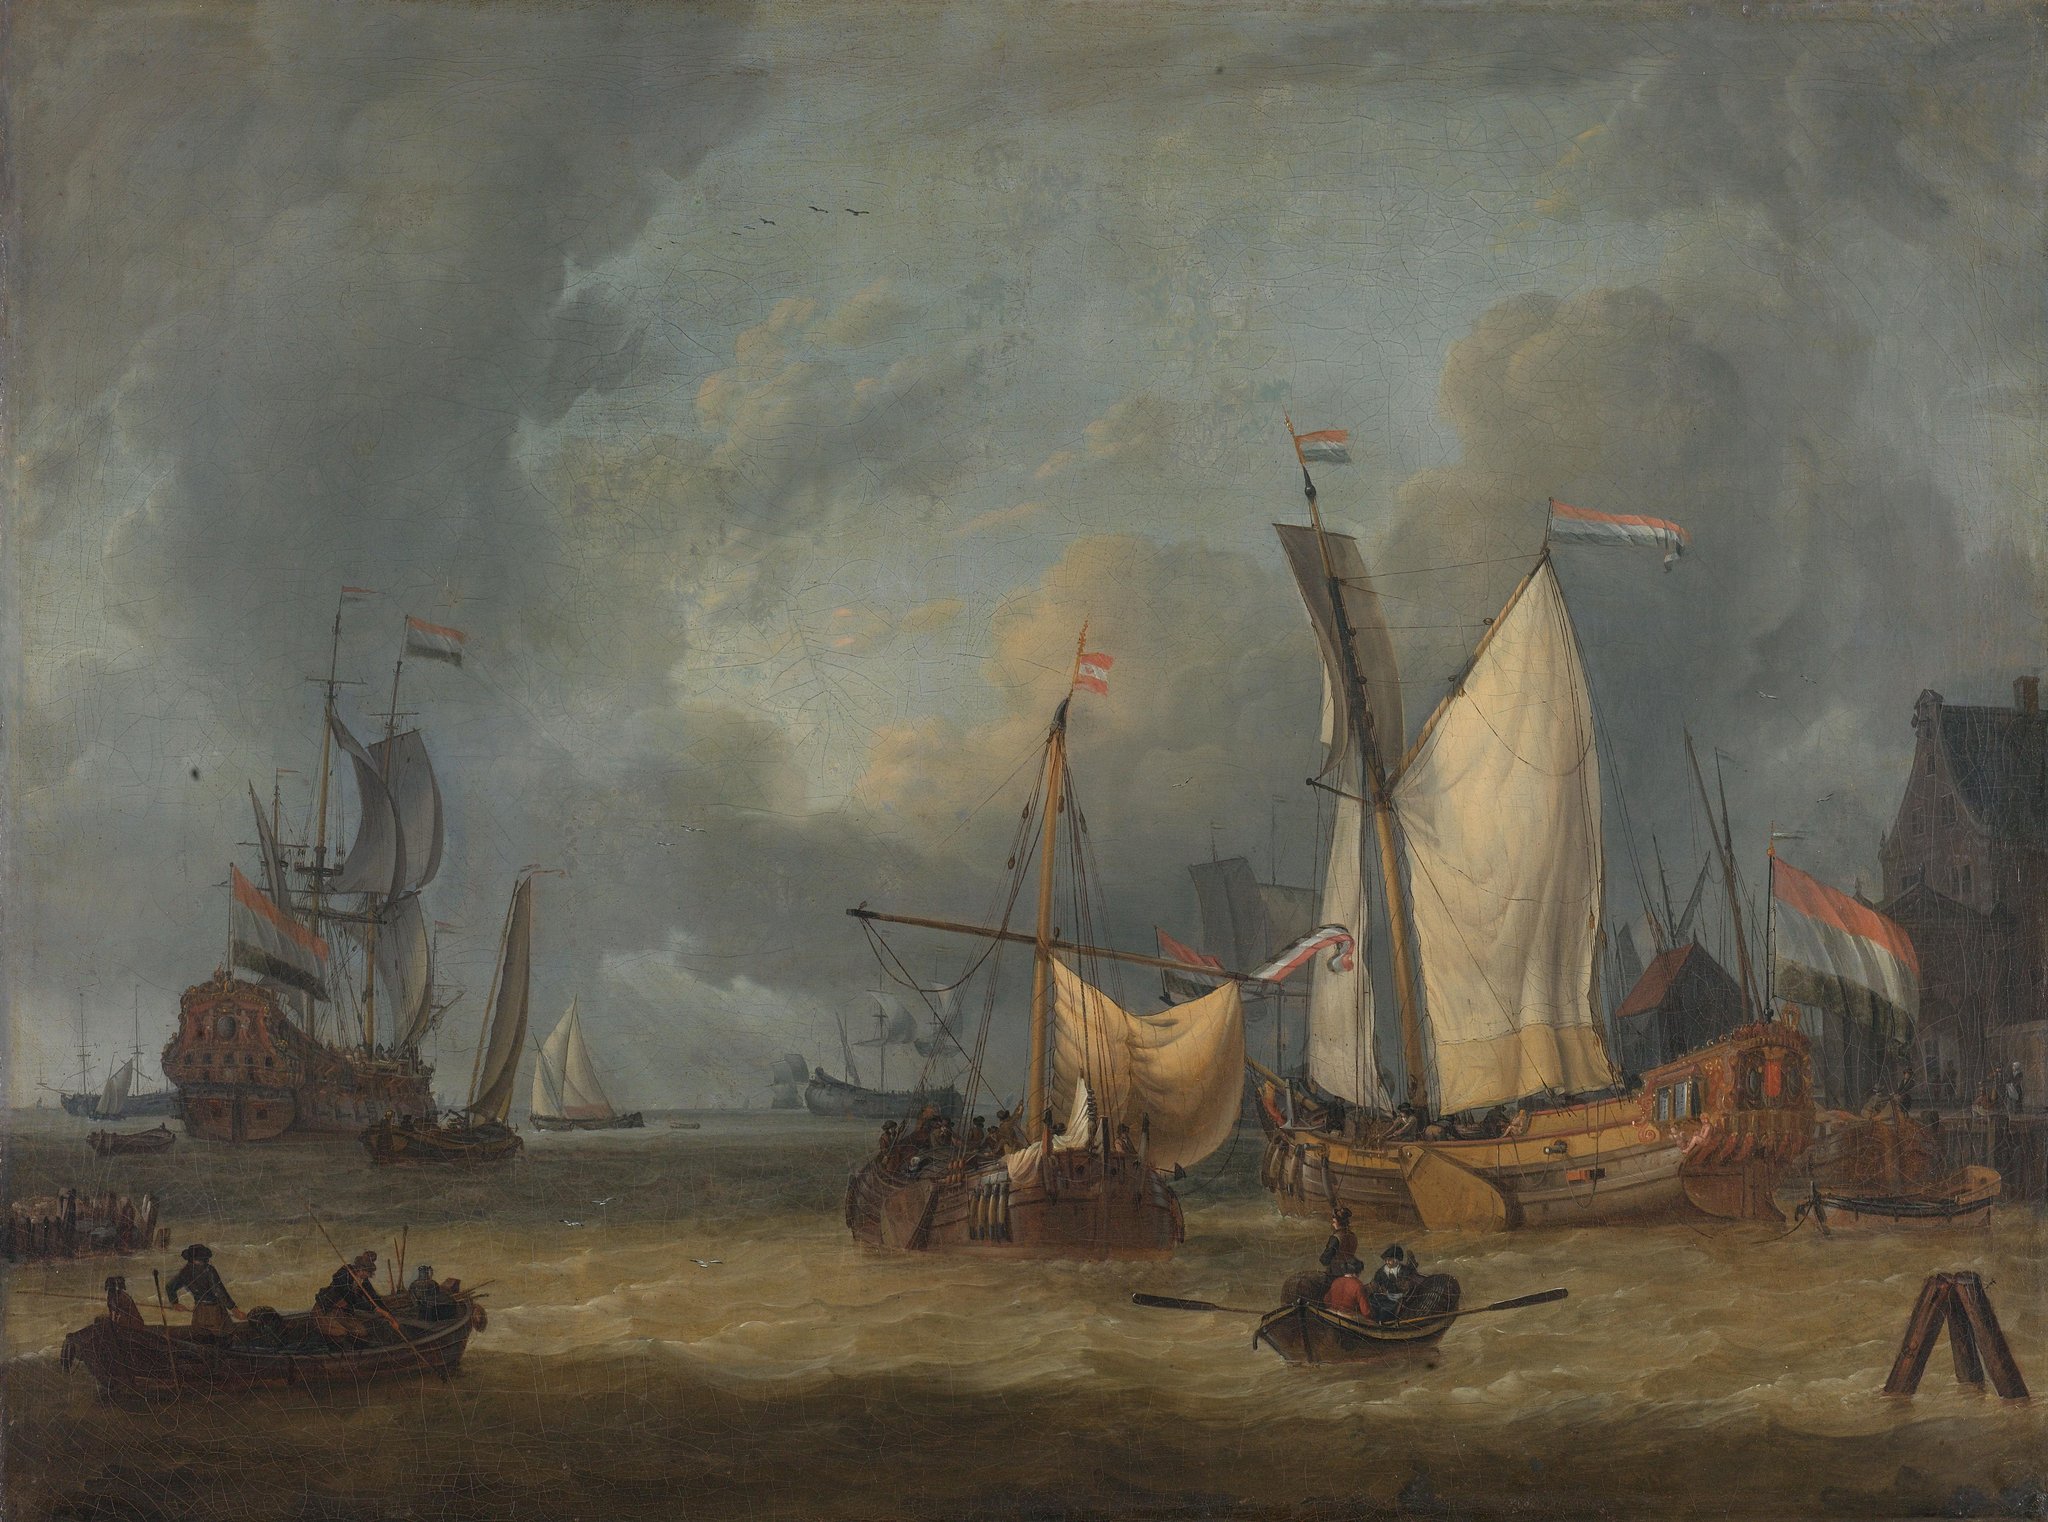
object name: painting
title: A Storm (Ships in the Harbor in a Stiff Breeze)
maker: jan claesz. rietschoof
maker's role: painter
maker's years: 1652-1719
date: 1675-1719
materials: canvas, oil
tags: harbour, sailing-ship, sailing-boat, sea (seascape)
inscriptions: signature: ‘JCR’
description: Schepen in de haven bij een stevige bries. Rechts aan de kade ligt een jacht met vlaggen en het embleem van de Hollandse Tuin op de spiegel. Op de voorgrond enkele roeiboten, links een oorlogsschip. Pendant van SK-A-333.